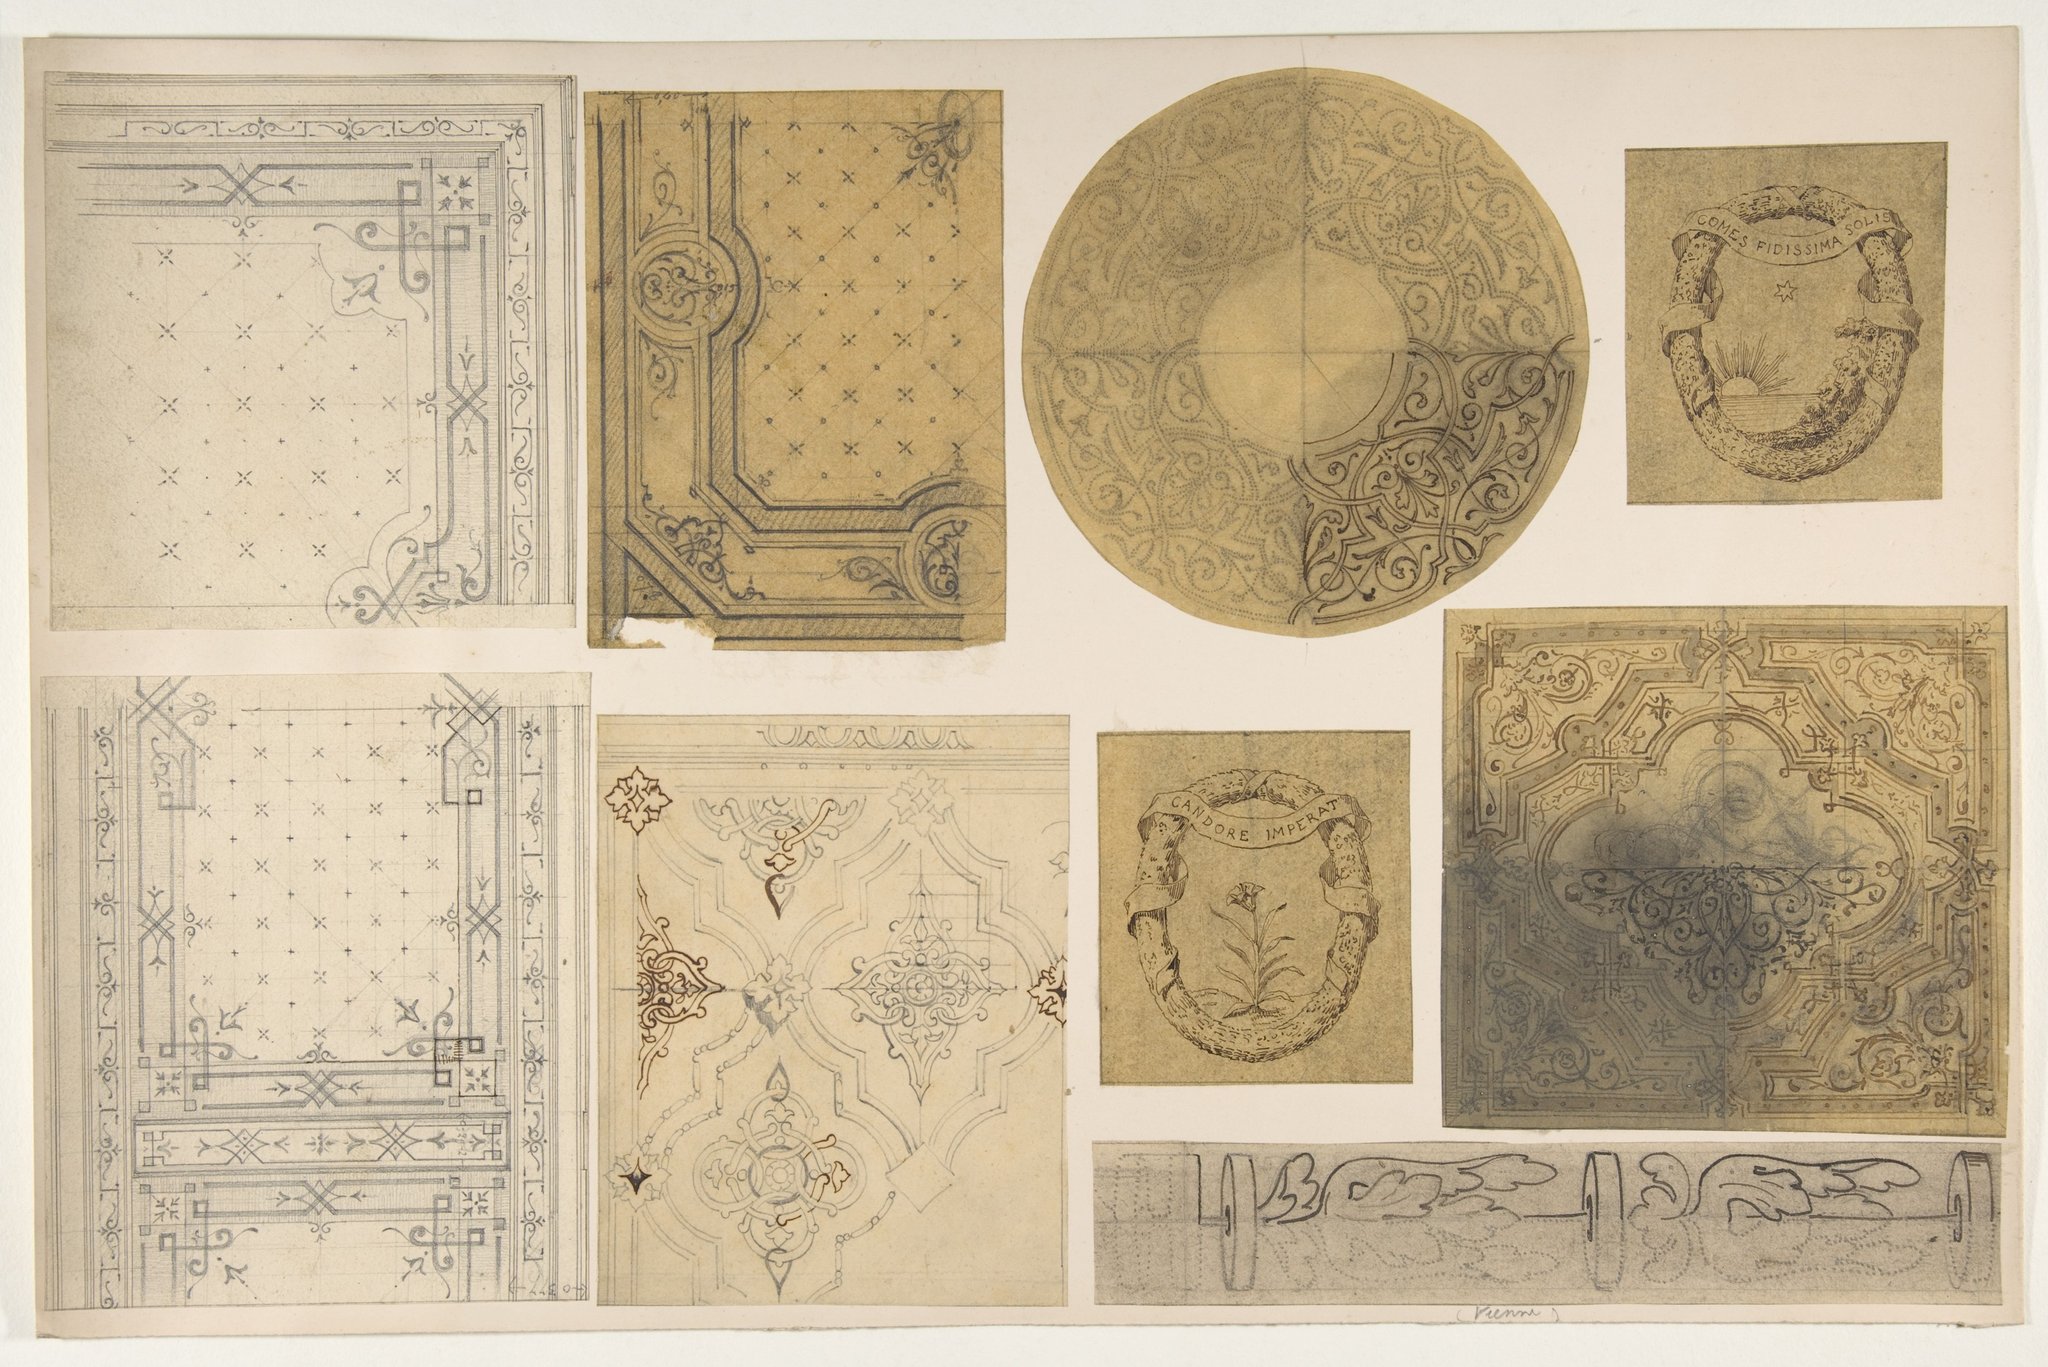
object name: drawing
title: Nine designs for the painted decoration of an interior, possibly for the Hôtel Rothschild, Vienna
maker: jules-edmond-charles lachaise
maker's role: artist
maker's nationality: french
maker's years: 1897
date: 1851-1900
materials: cardboard, graphite, ink, paper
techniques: pen